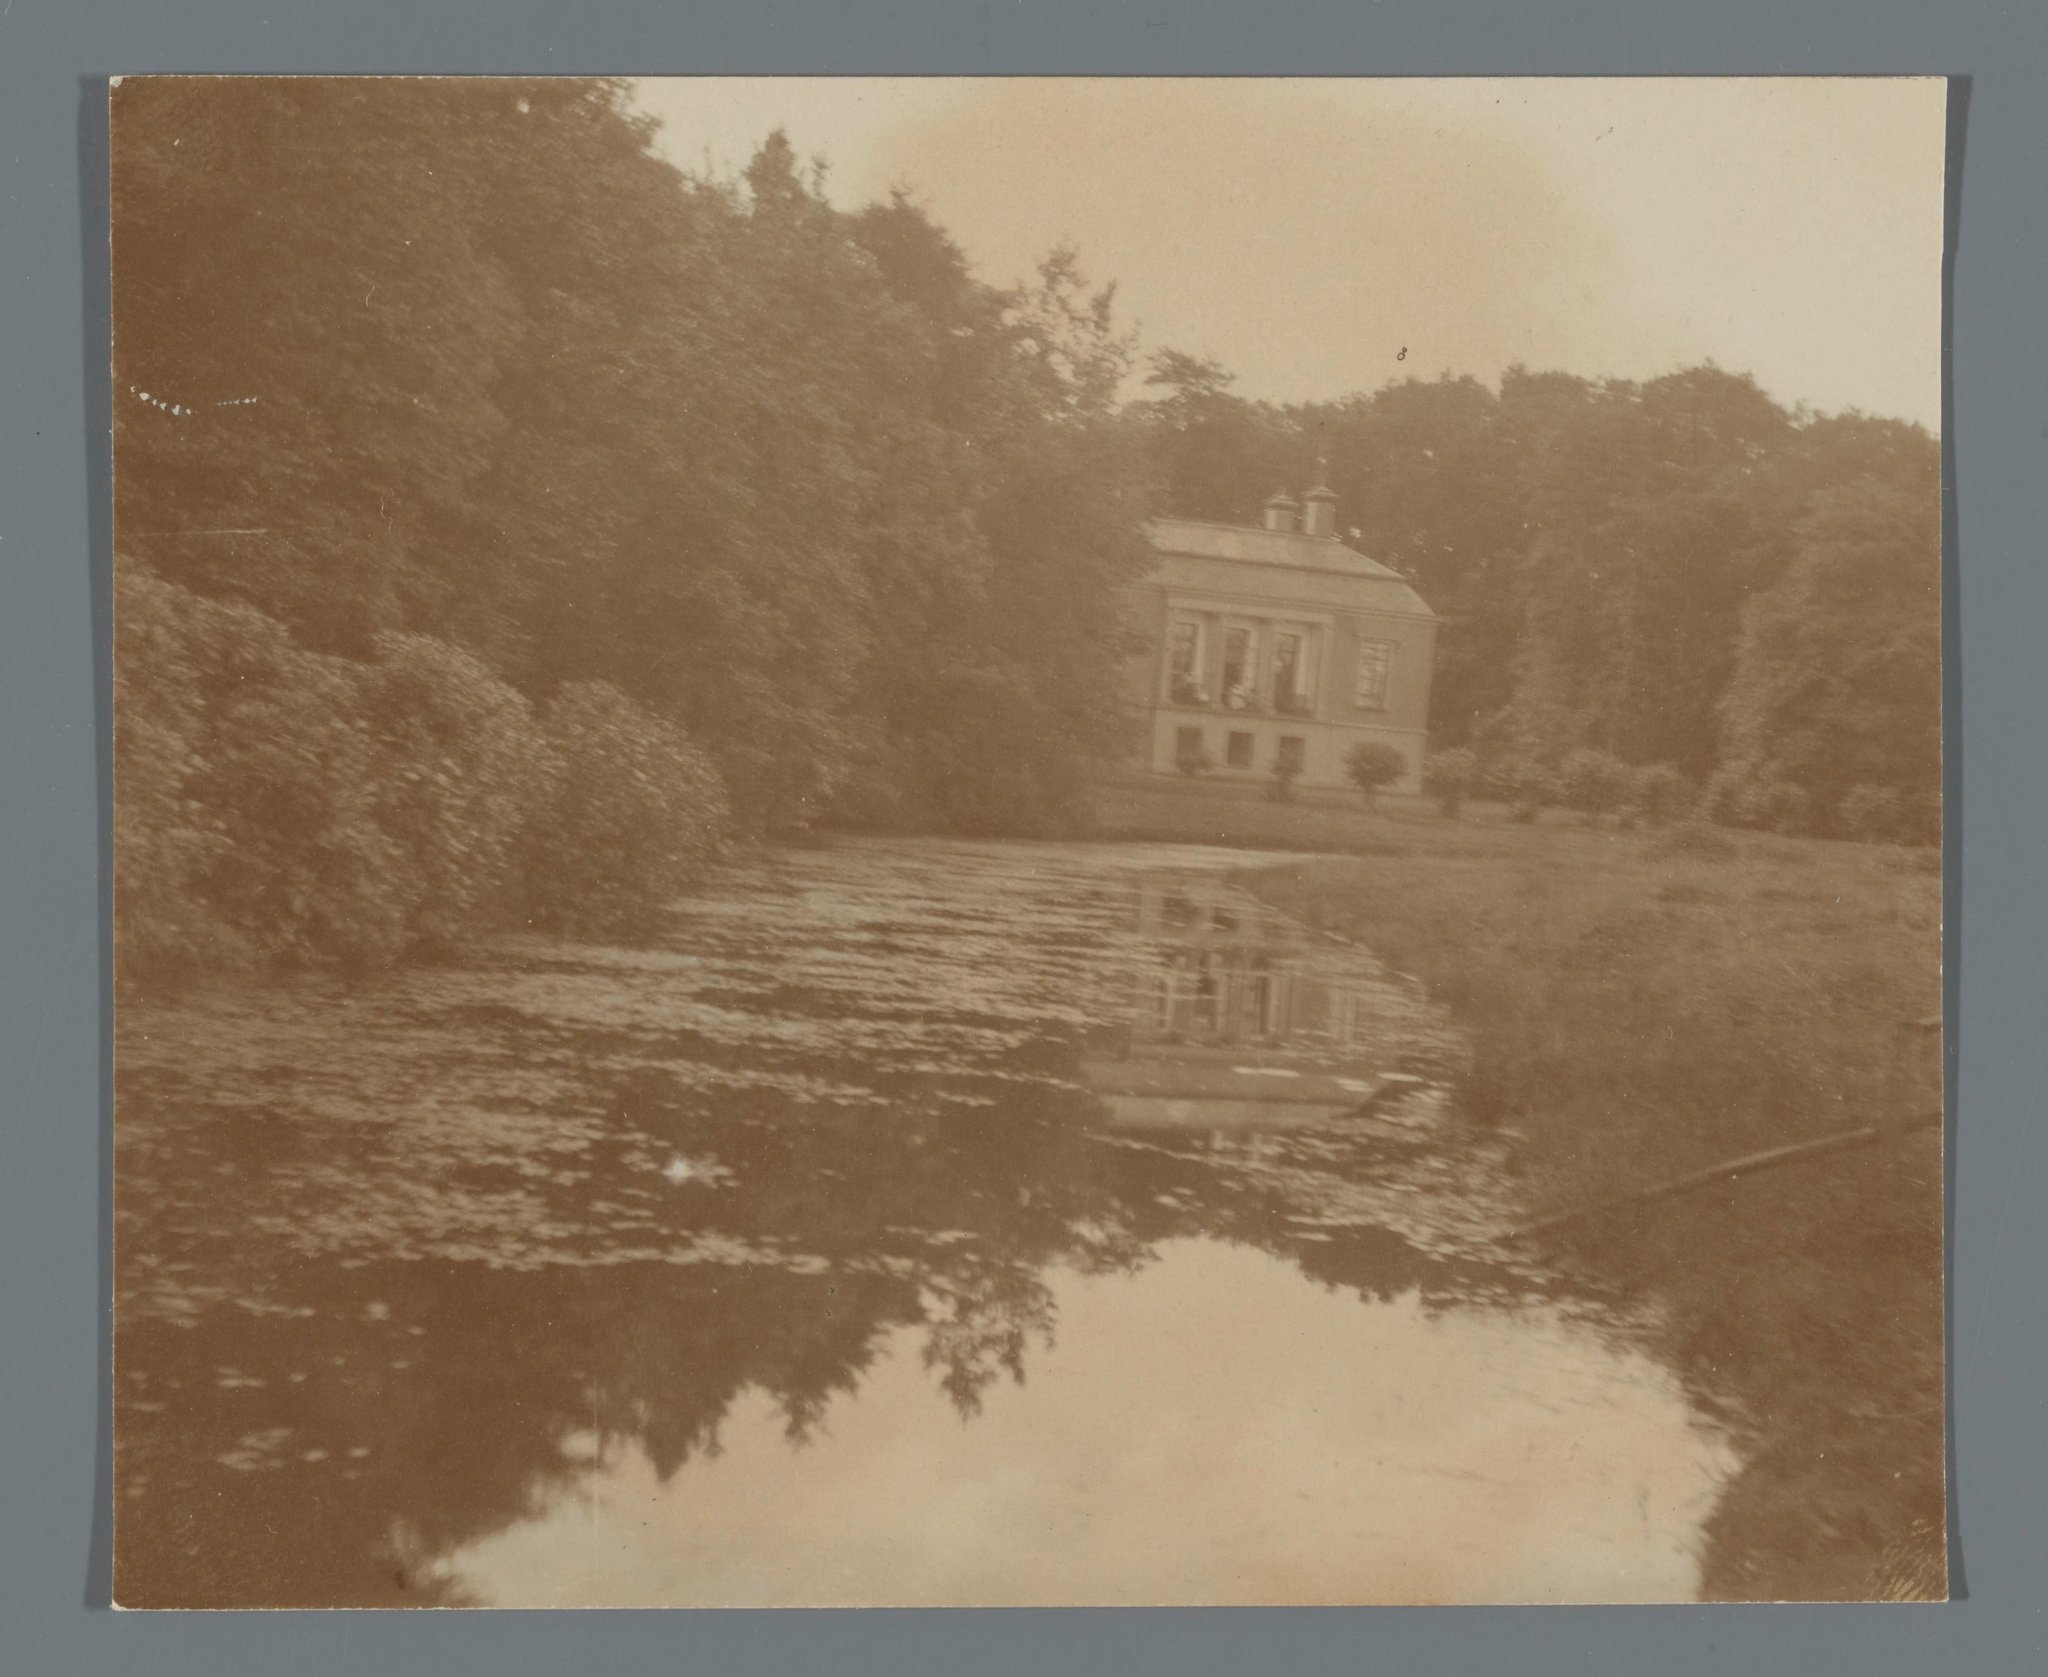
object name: photograph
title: Gezicht op een landhuis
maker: cornelia hendrika jonker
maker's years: 1874-1924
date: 1880-1920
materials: photographic support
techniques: collodion silver print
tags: rural housing, e.g. country-house, villa, cottage